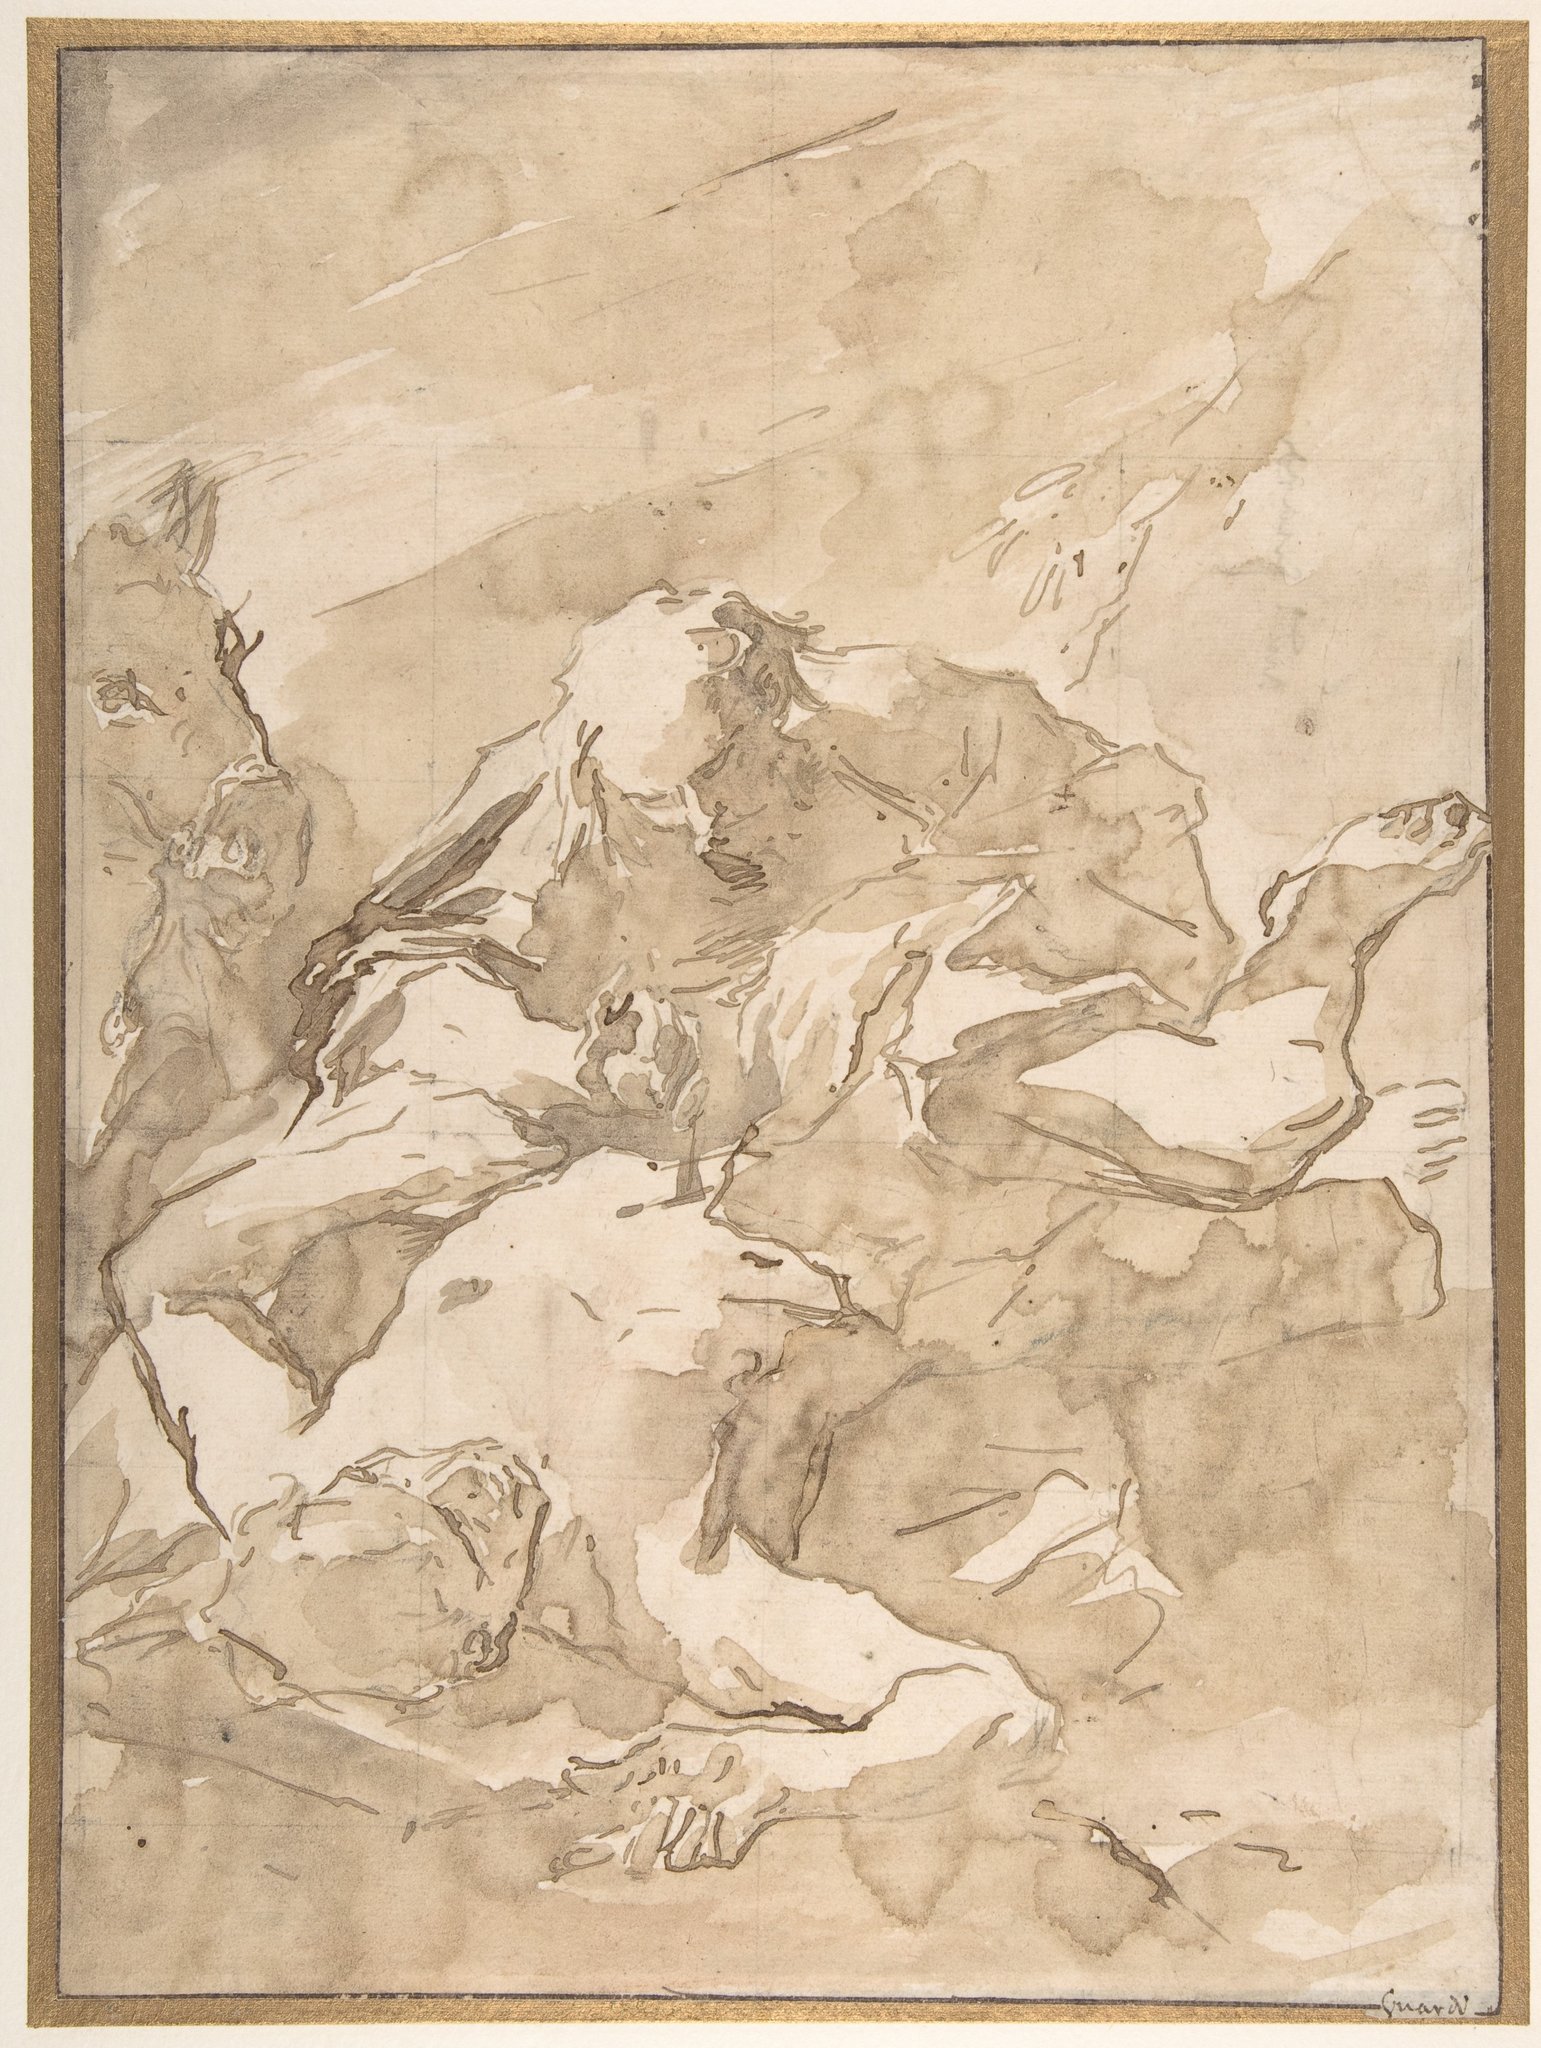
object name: drawing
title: The Good Samaritan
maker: giovanni antonio guardi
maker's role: artist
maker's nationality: italian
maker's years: 1699-1766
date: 1699-1766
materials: chalk, ink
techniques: brush, pen, drawing, transfer, wash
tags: men,horses